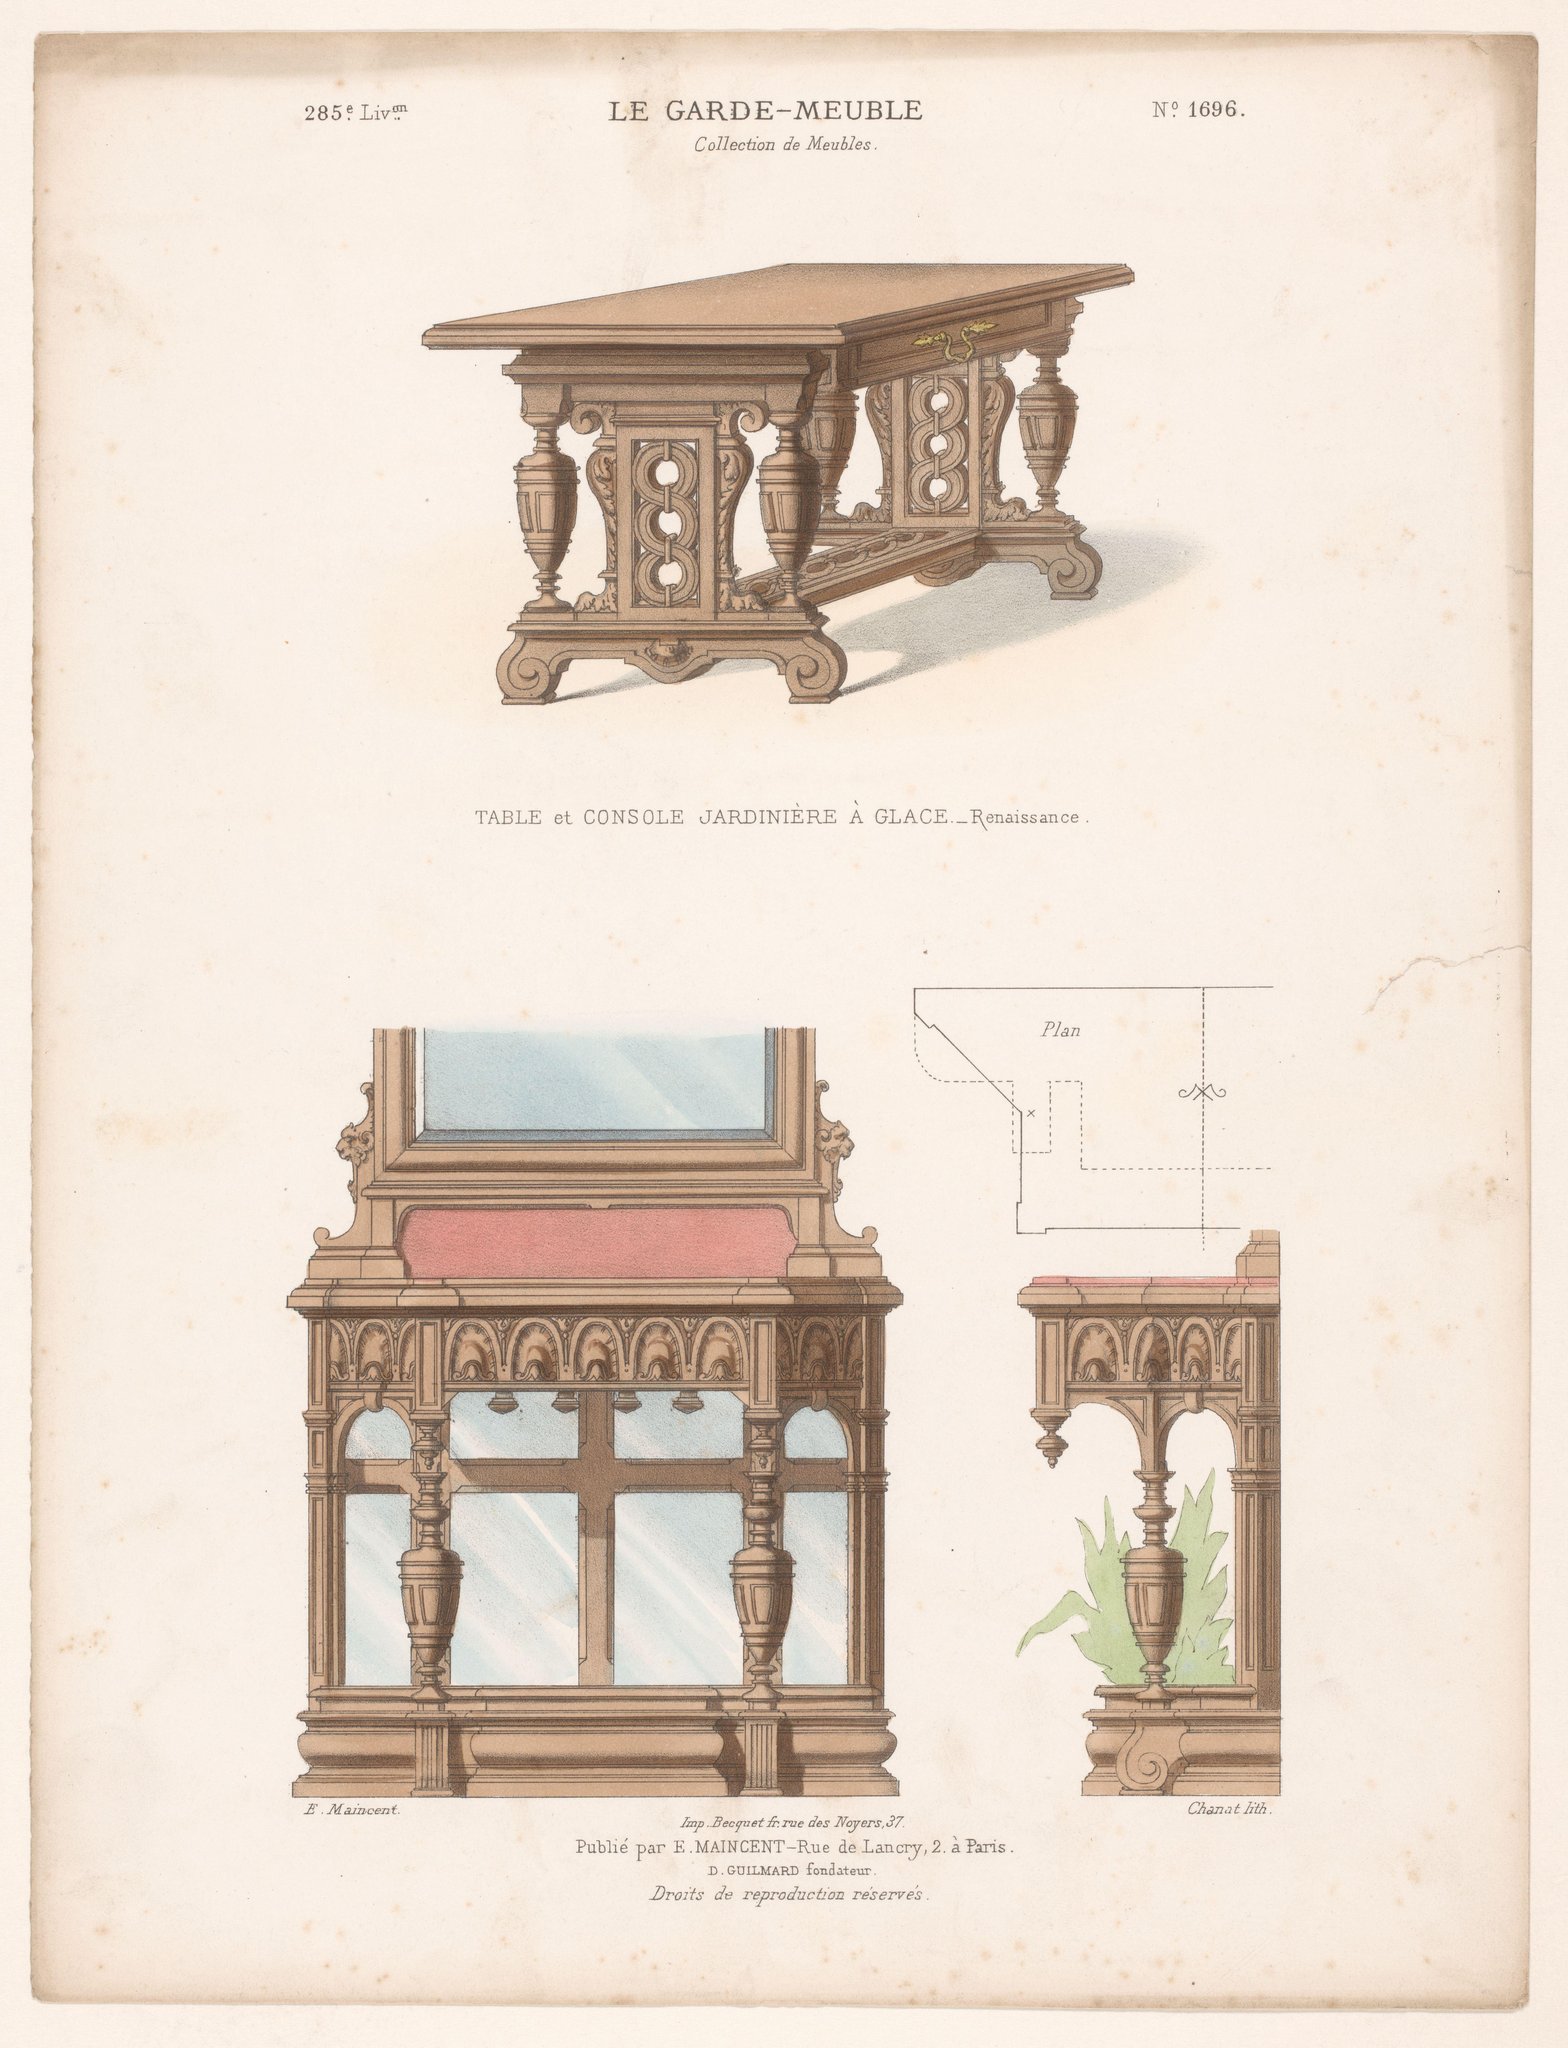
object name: print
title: Tafel en jardinière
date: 1885-1895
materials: paper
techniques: hand coloring, lithograph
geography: paris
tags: table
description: Ieder Livraison in de serie Le Garde-Meuble bevat negen platen: drie 'sièges' (zitmeubels), drie 'meubles' (diverse meubels zoals tafels en kasten) en drie 'tentures' (gordijnen en draperieën).